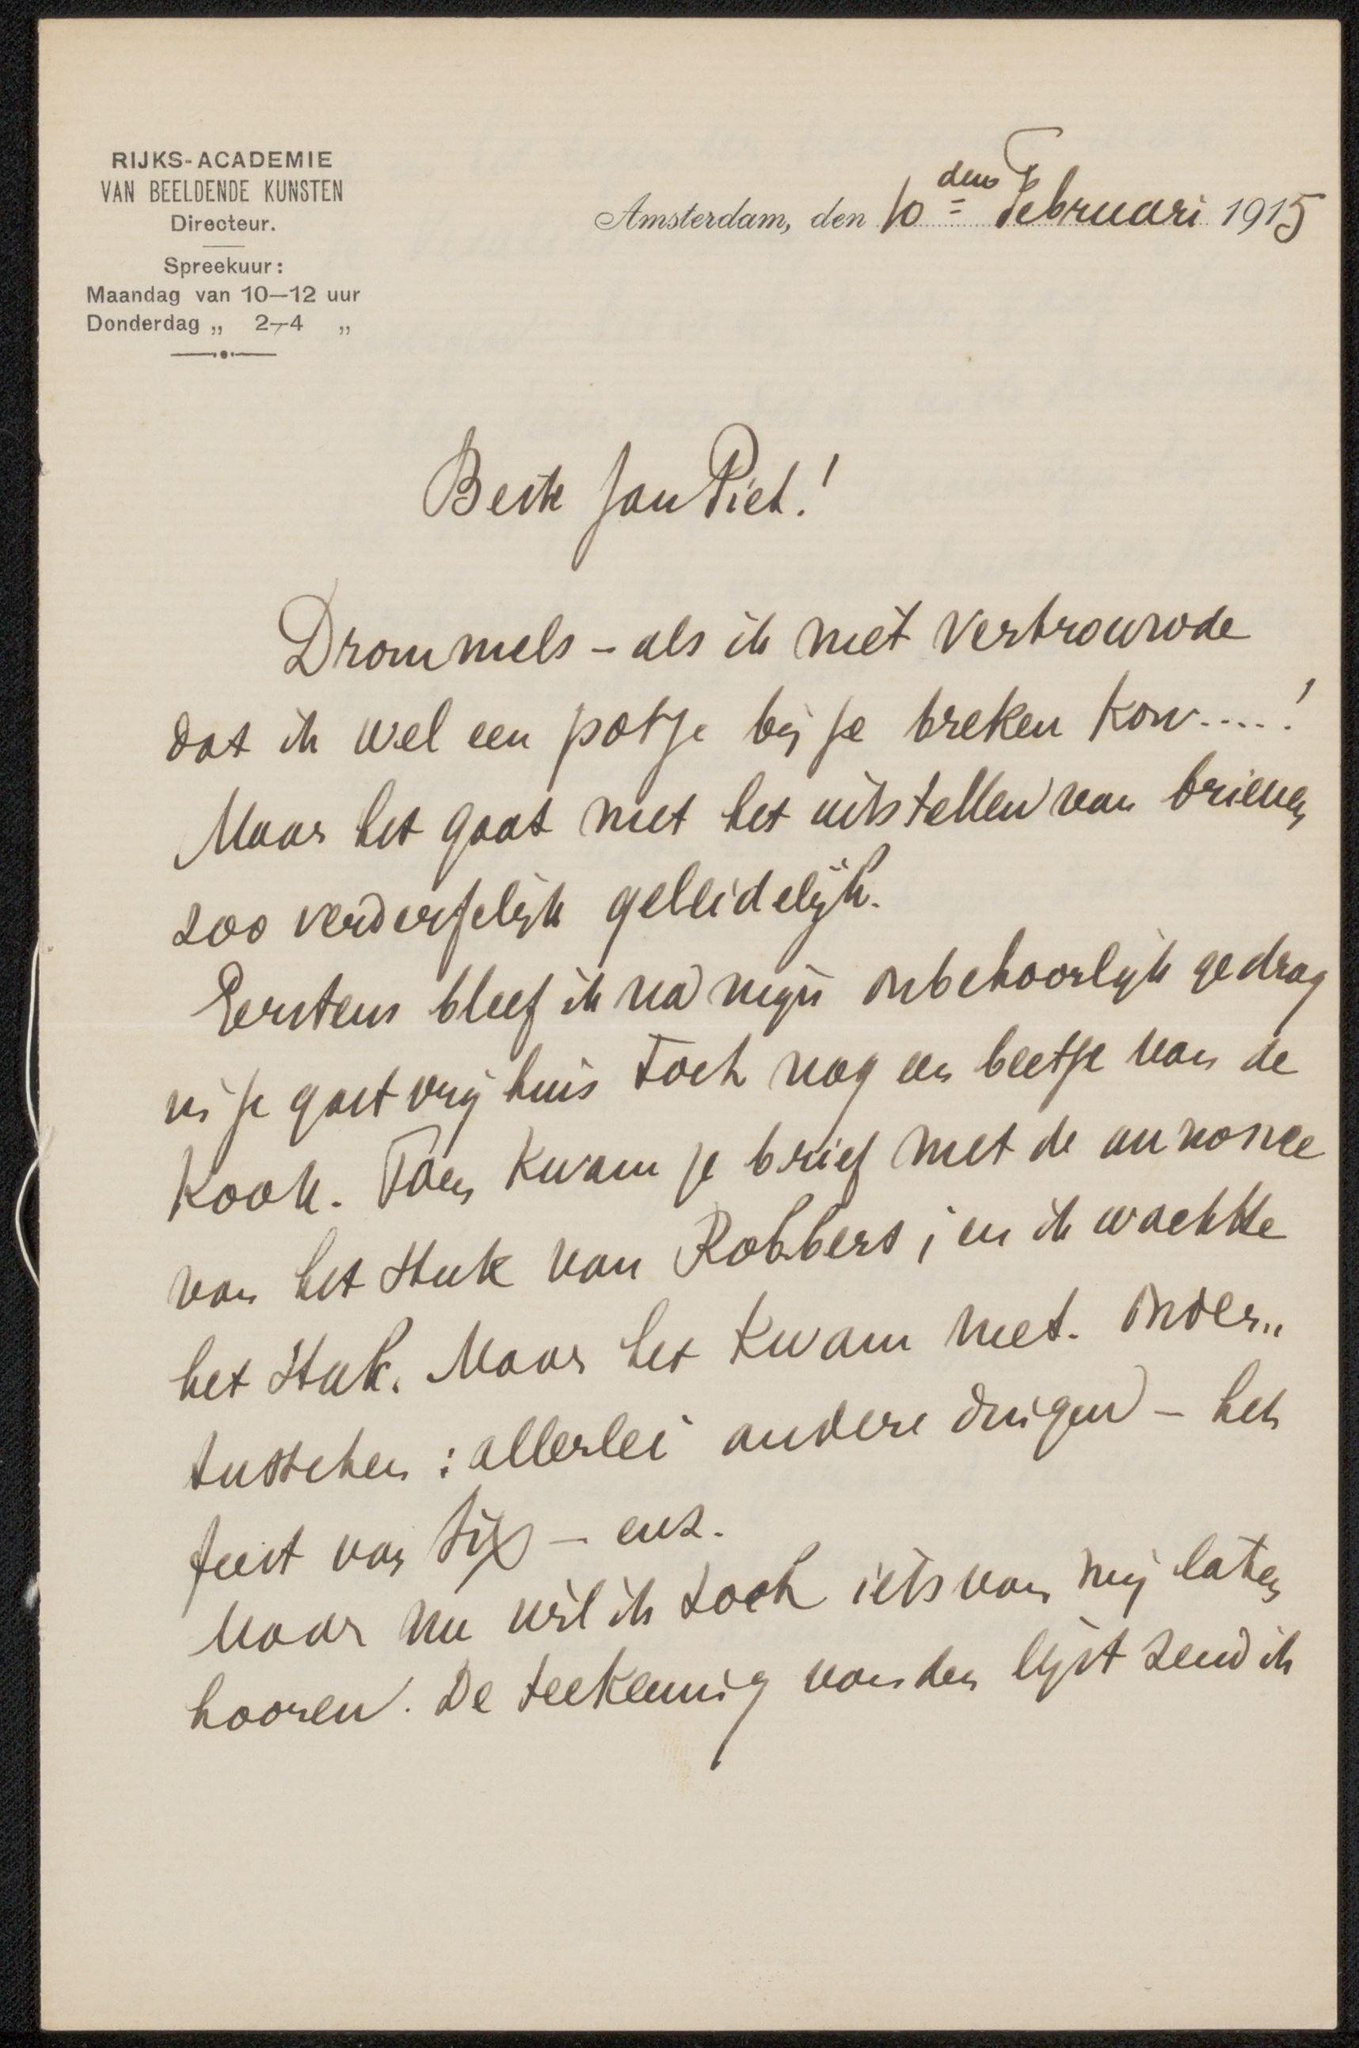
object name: letter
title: Brief aan Jan Veth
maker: antoon derkinderen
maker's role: draughtsman, painter, print maker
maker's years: 1859-1925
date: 1915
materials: ink, paper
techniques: pen, printing, writing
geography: amsterdam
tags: dordrecht, painter, print maker, draughtsman, designer, jan veth, jonkheer jan six, rotterdam, amsterdam, herman robbers, drawing, printed matter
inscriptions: collector's mark: ‘RPK’